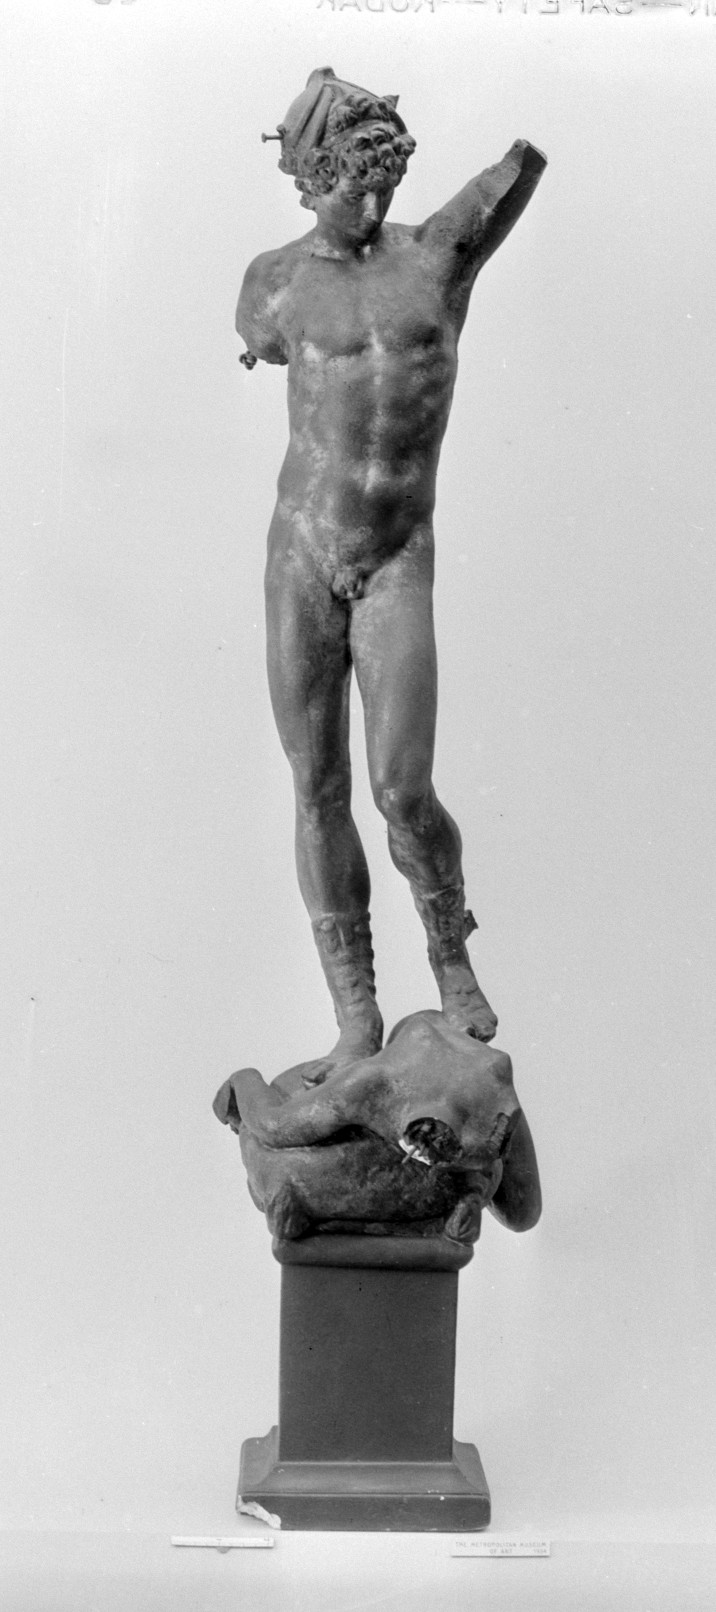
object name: statue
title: Perseus with the Head of Medusa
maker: benvenuto cellini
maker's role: artist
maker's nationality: italian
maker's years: 1500-1571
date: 1801-1900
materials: gilt, plaster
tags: perseus